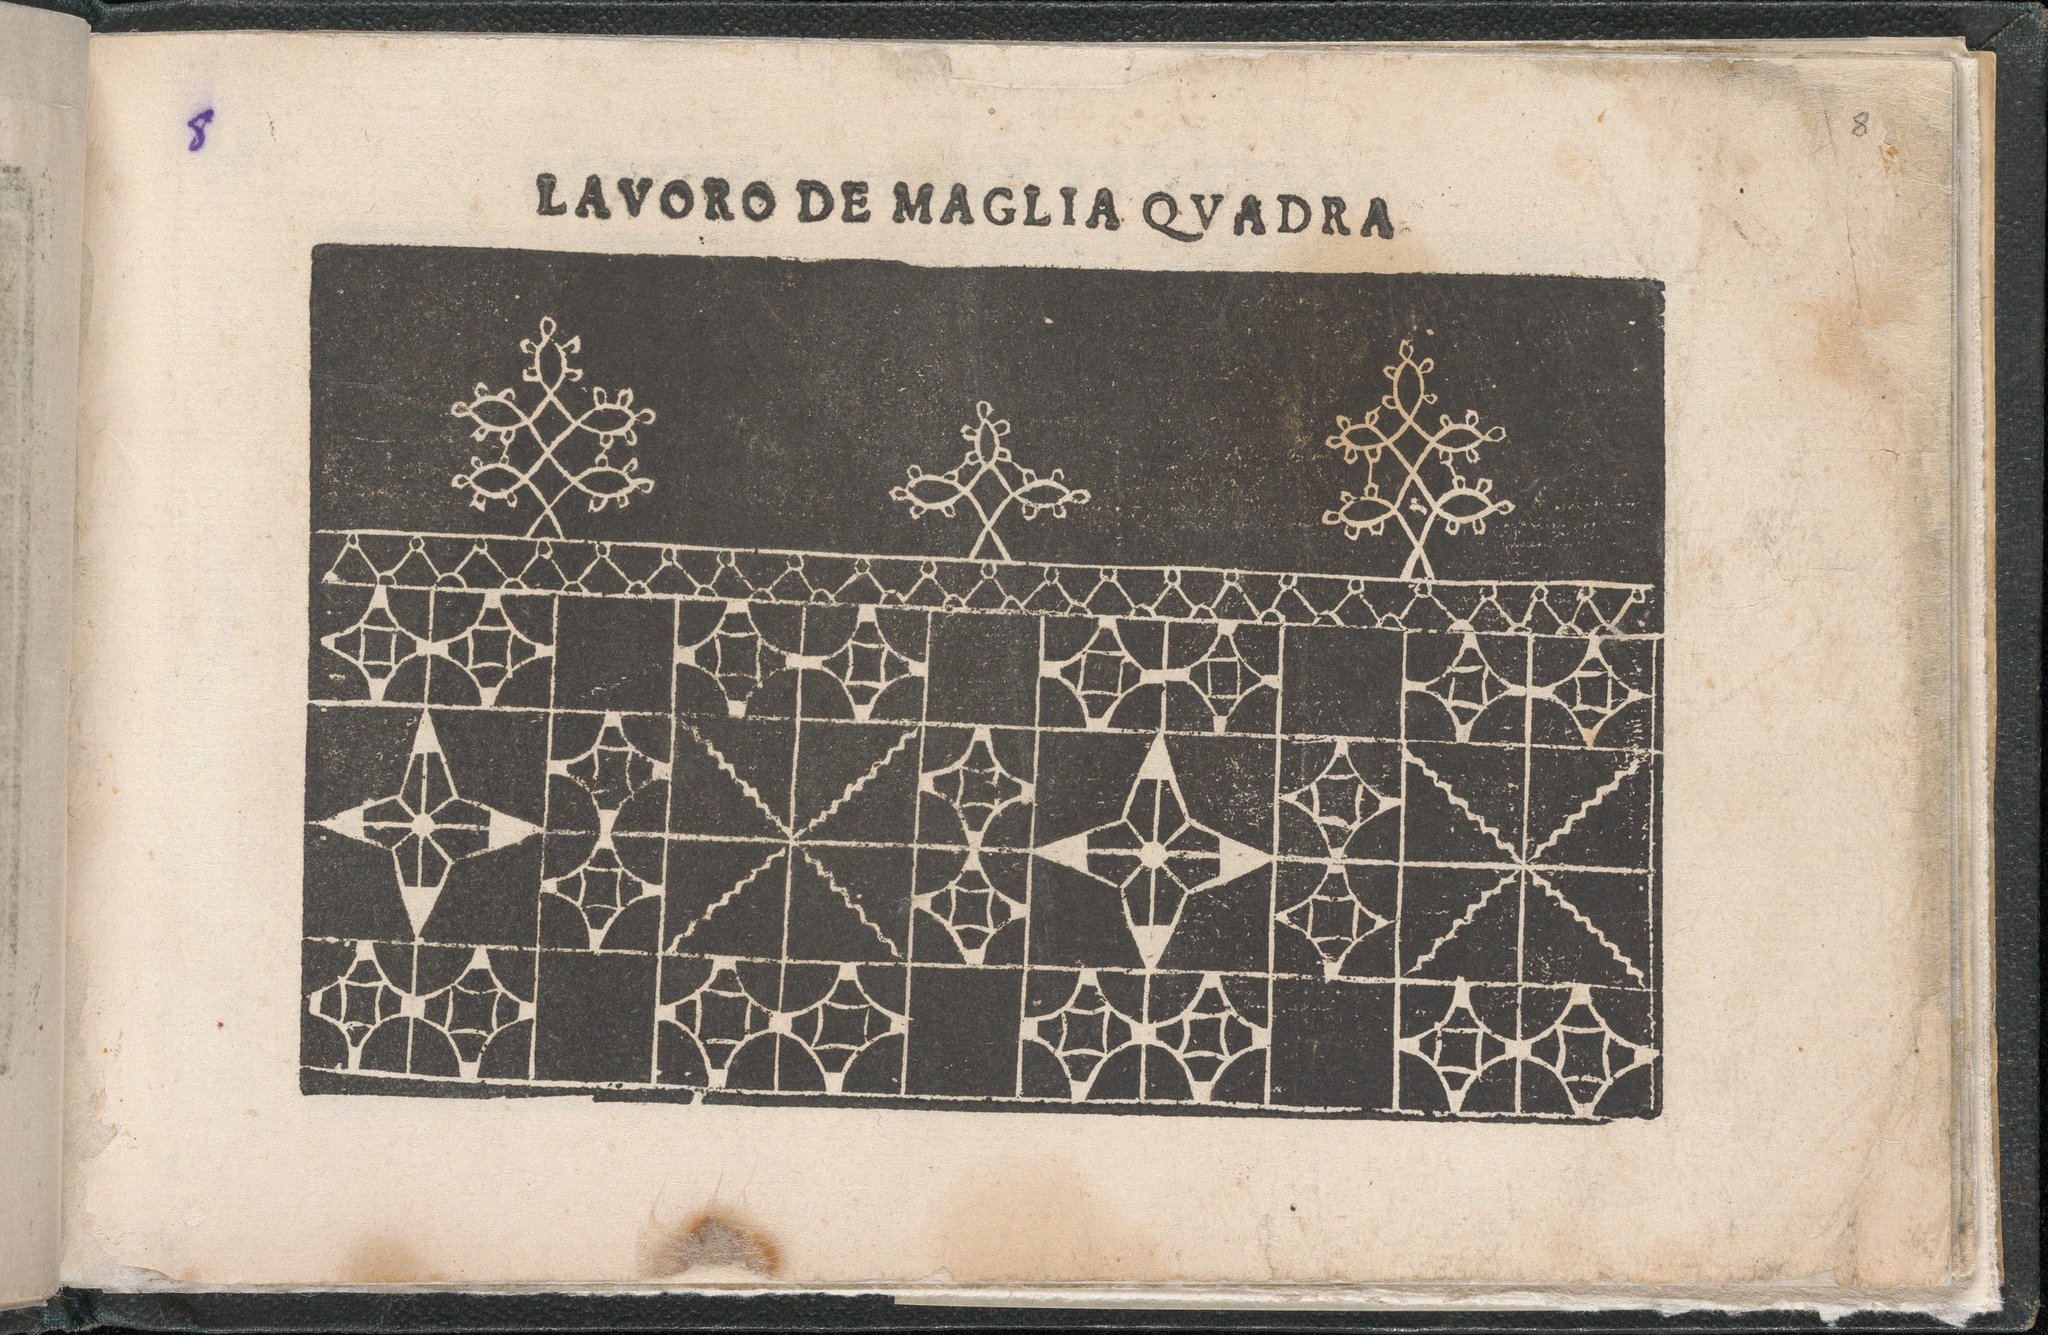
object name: book print ornament architecture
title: Gemma pretiosa della virtuose donne, page 8 (recto)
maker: isabella catanea parasole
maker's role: designer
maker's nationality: italian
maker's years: 1565-1625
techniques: woodcut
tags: ornament